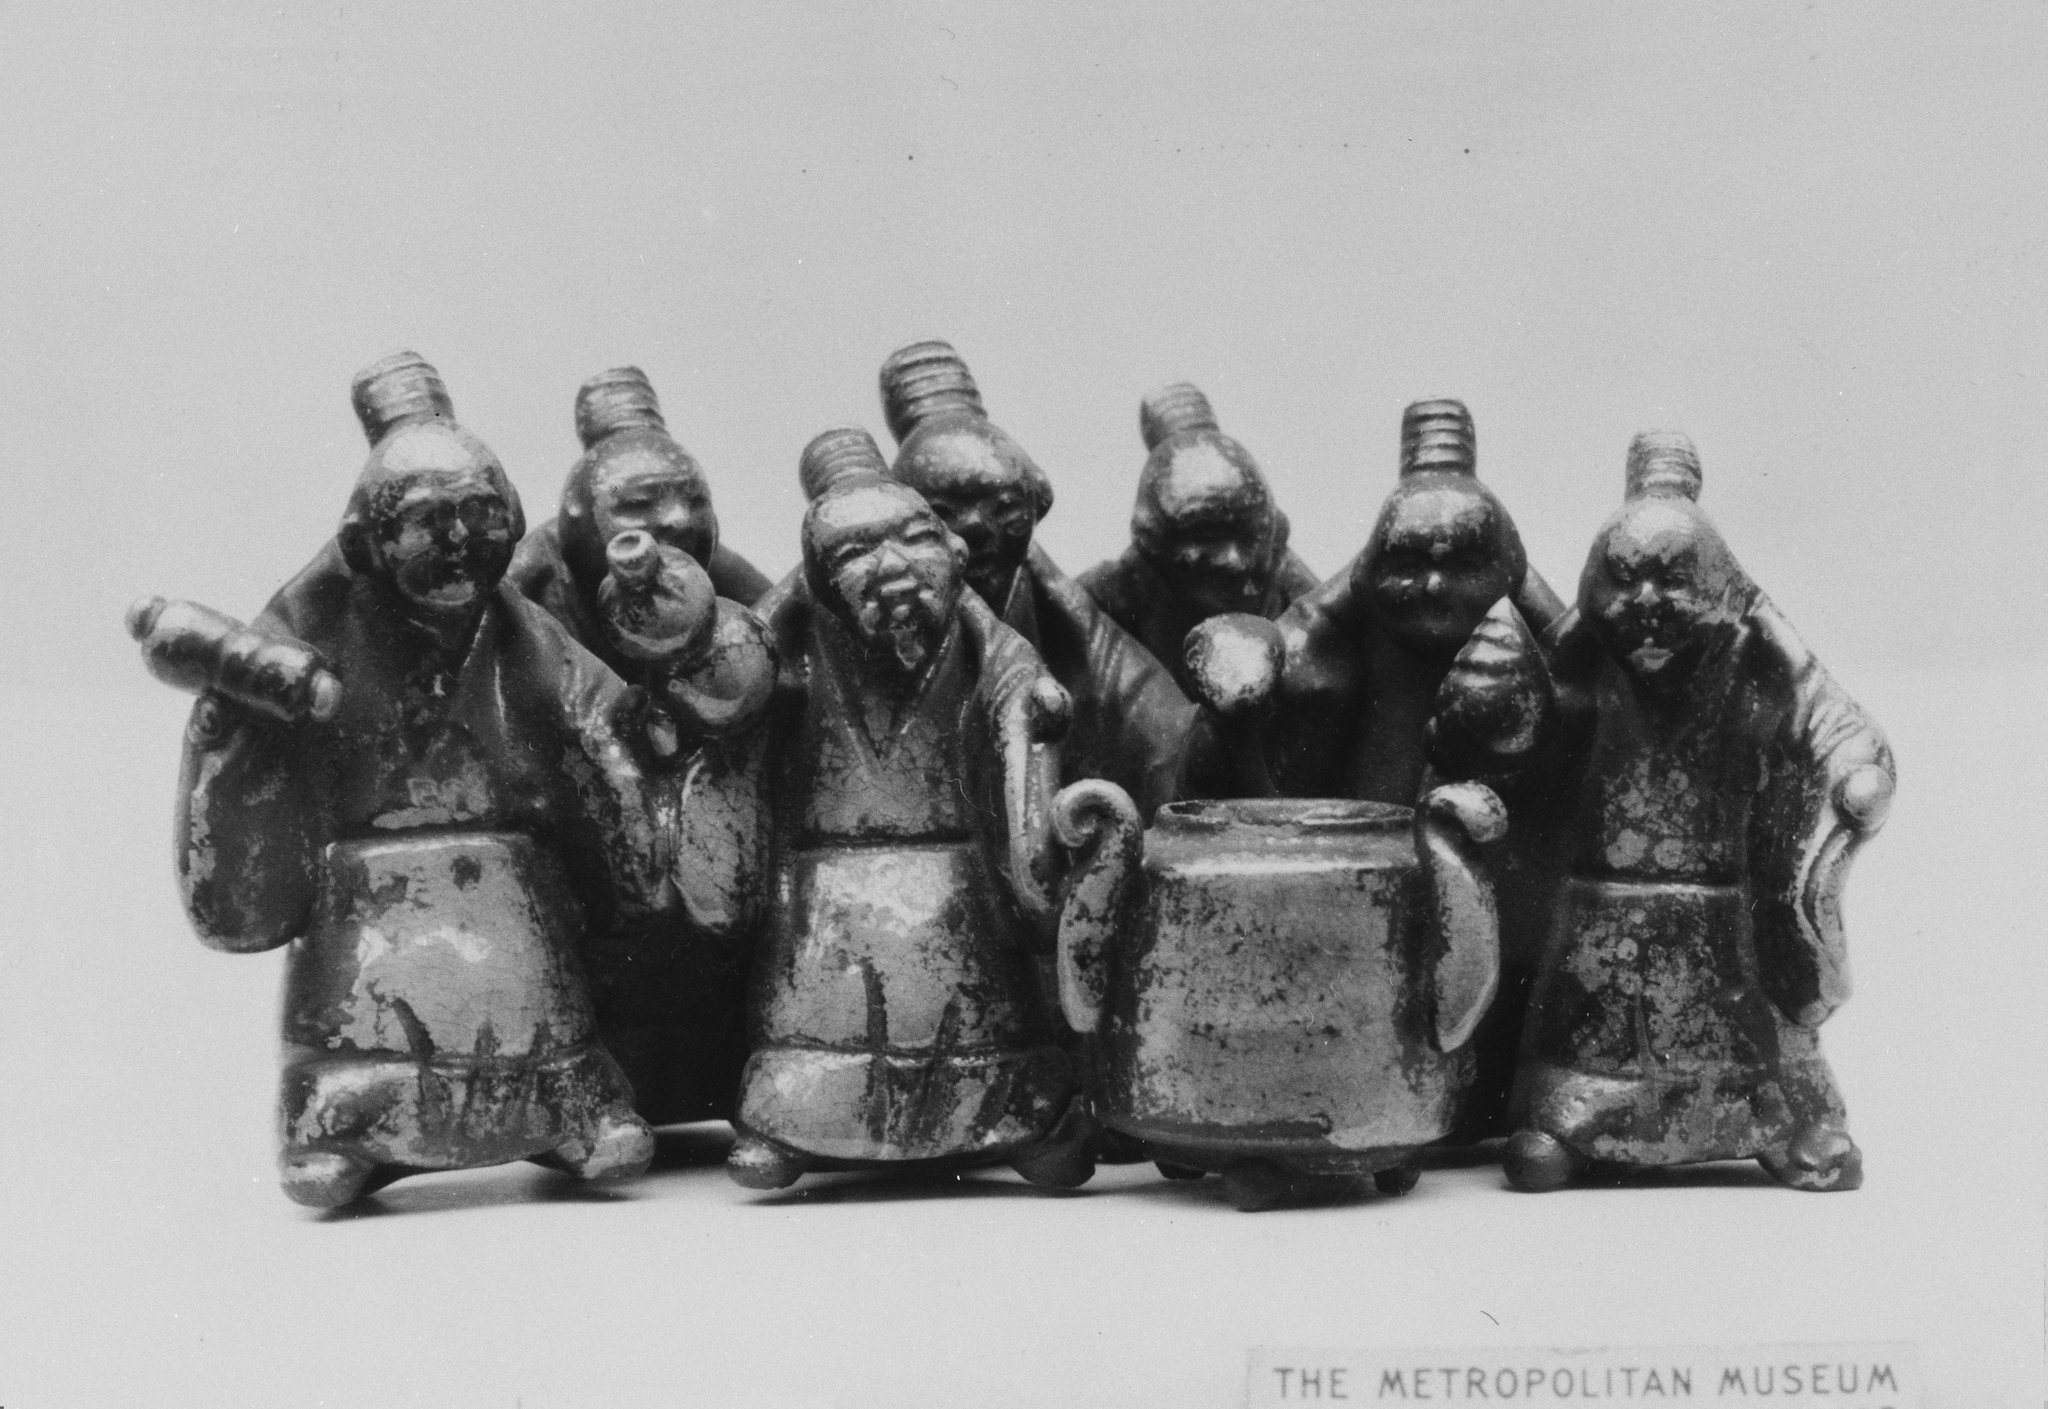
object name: pen rest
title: Group of Sennin Standing Around a Camp Kettle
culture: japanese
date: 1840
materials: faience, glaze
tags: men,kettles